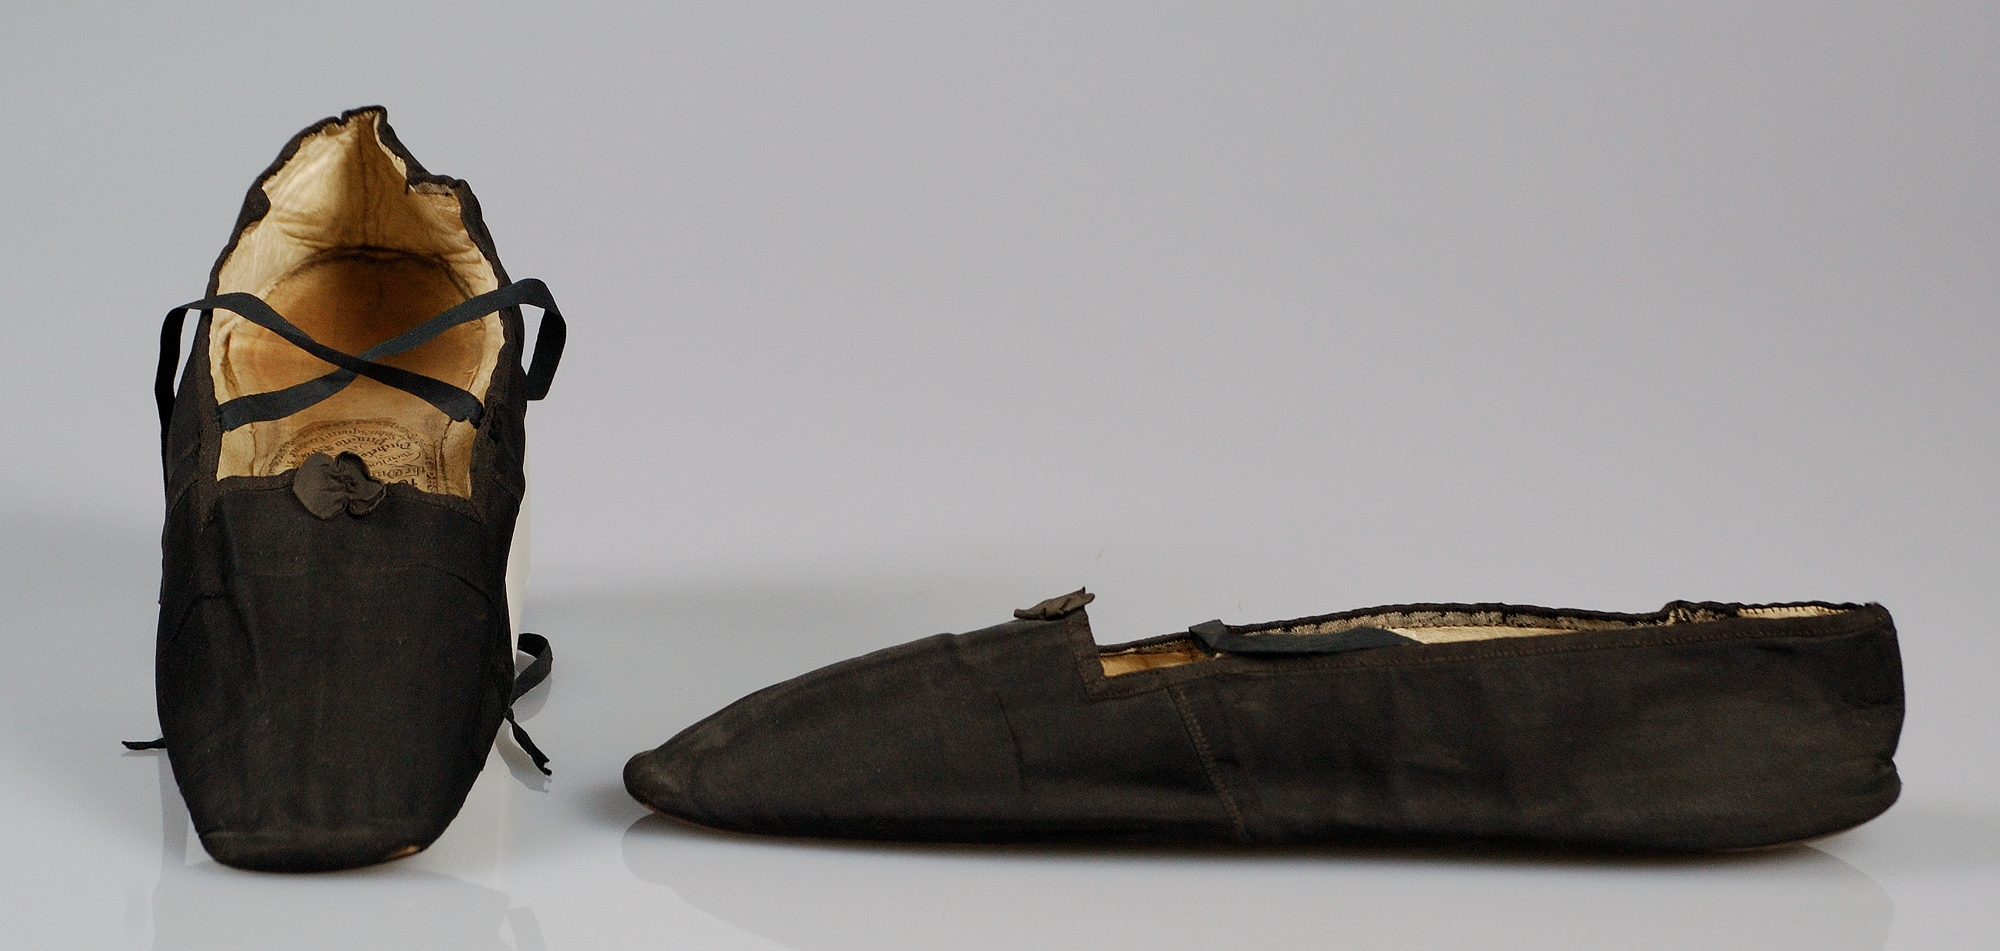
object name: evening slipper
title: Evening slippers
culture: british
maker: gundry & sons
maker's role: designer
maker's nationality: british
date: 1845-1865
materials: silk